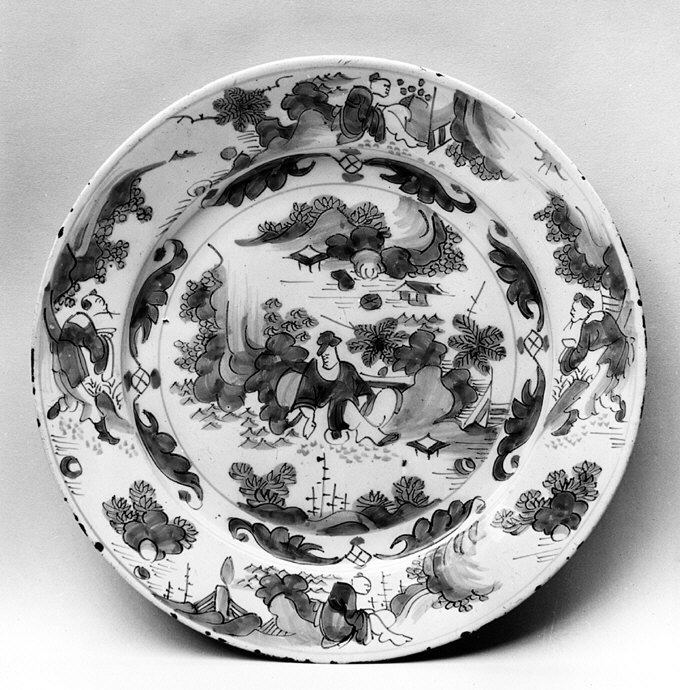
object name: plate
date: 1601-1800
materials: earthenware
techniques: glazing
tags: men